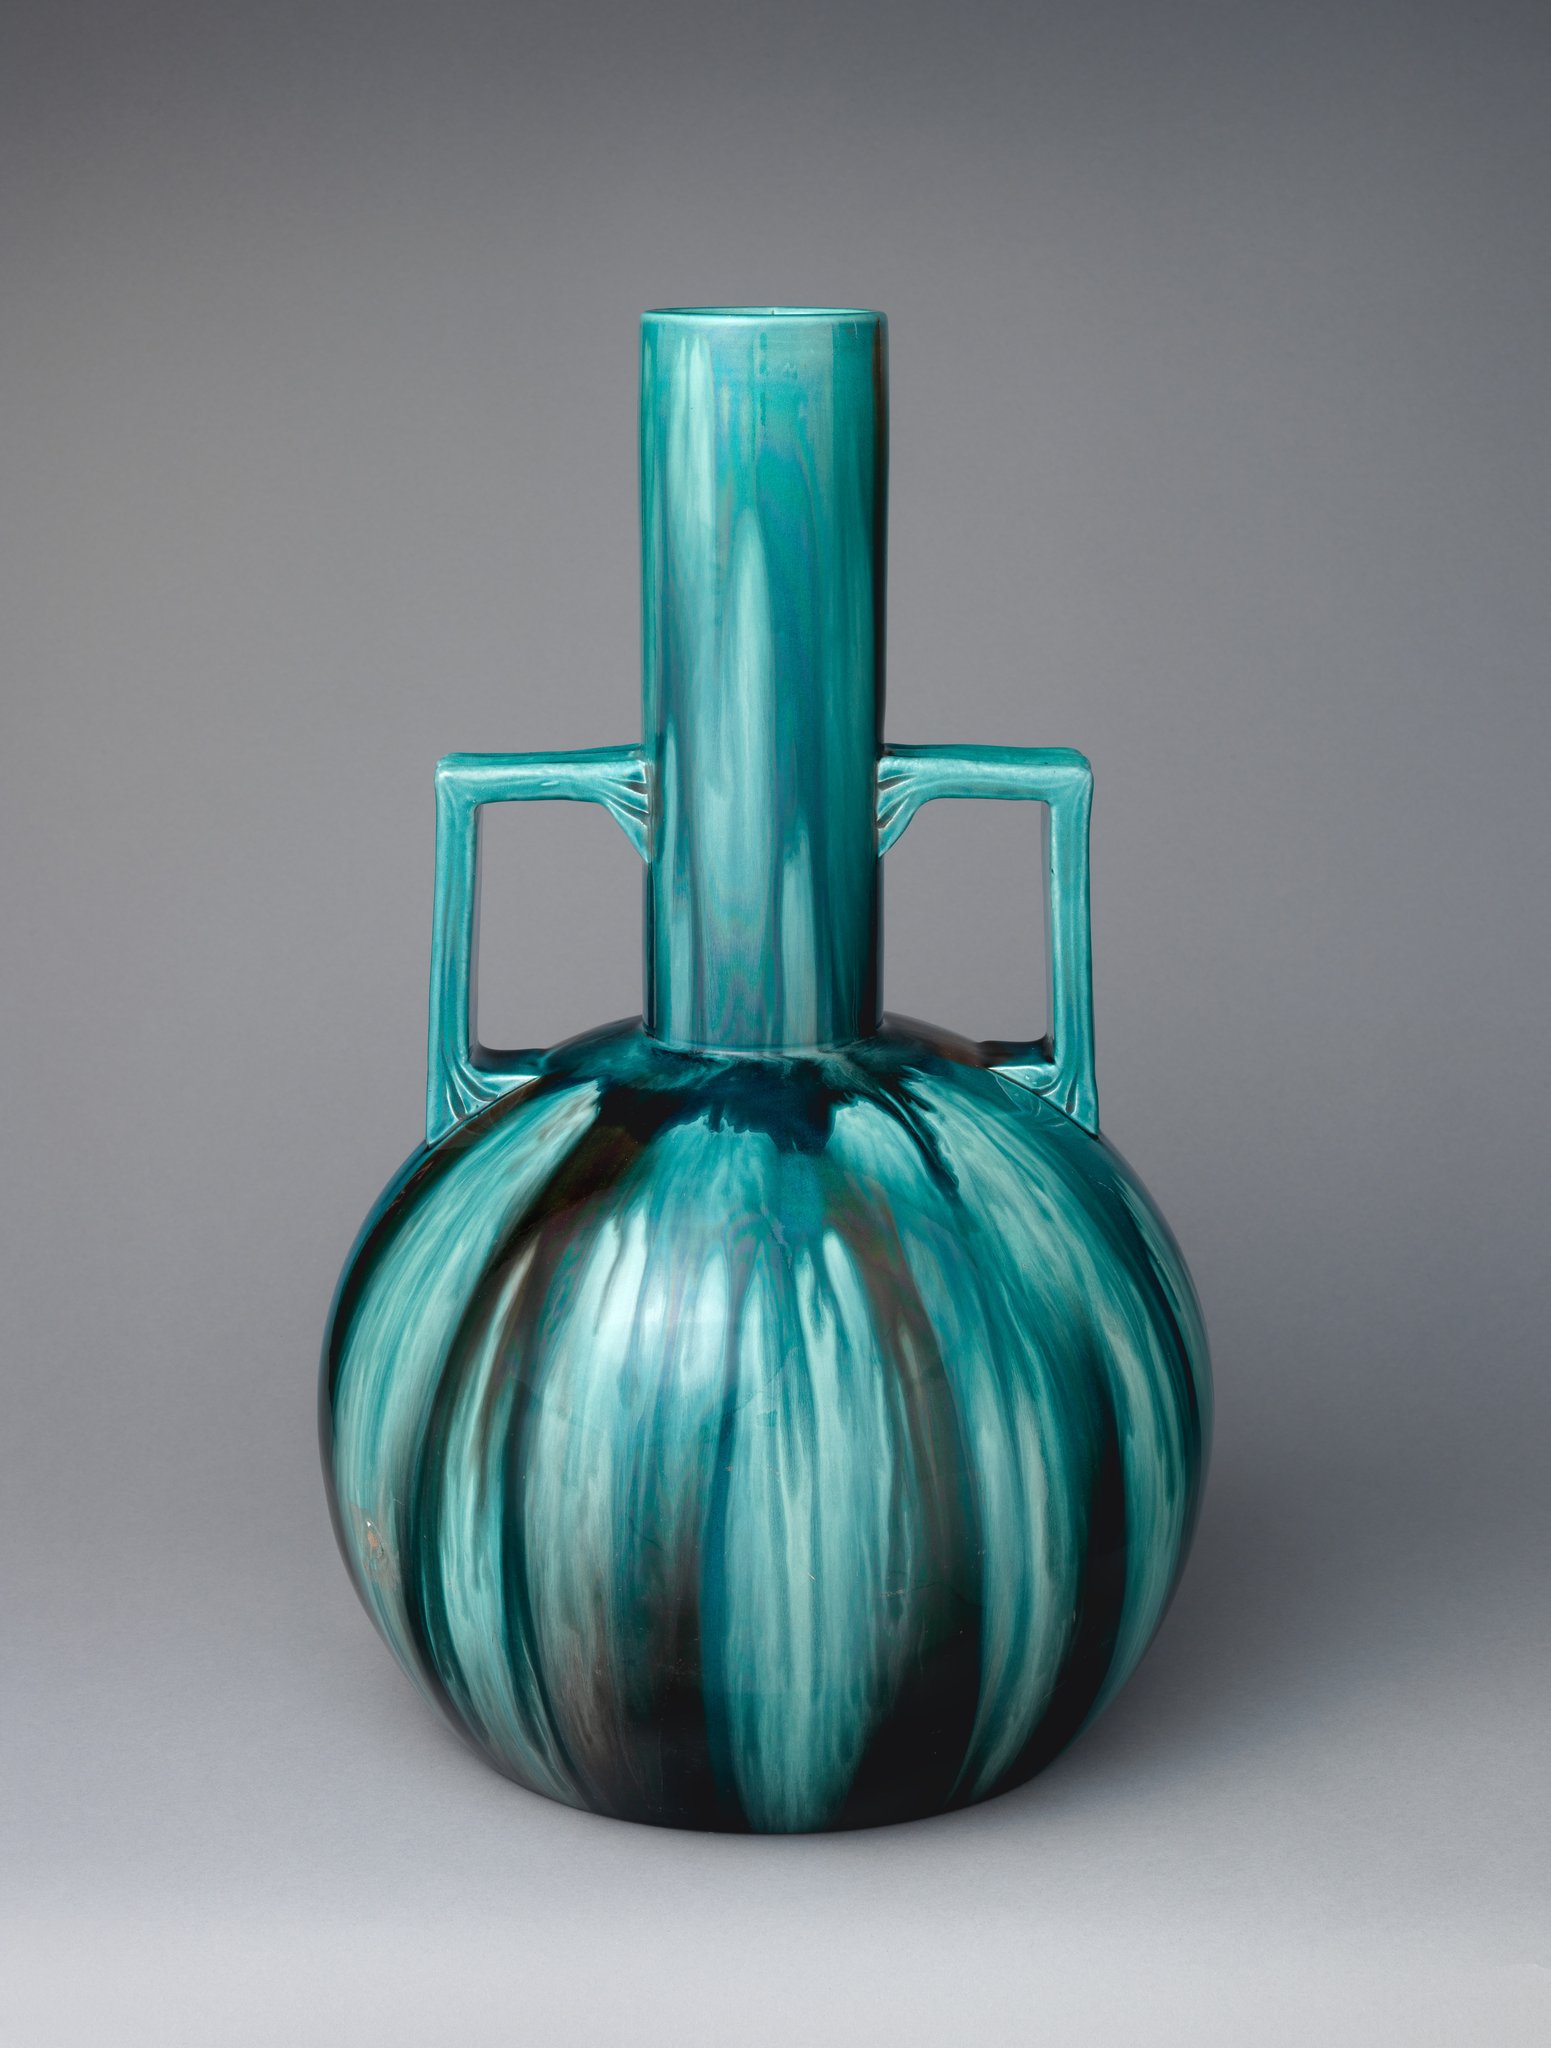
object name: vase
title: Tall vase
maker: christopher dresser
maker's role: designer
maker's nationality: british, scottish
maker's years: 1834-1904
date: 1892-1894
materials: earthenware